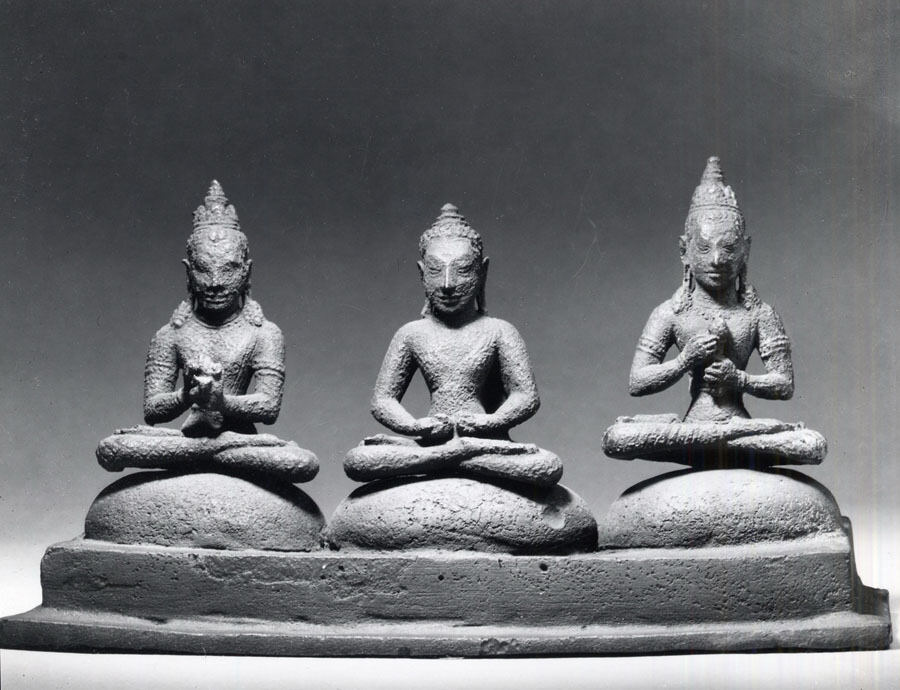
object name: figure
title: Buddhist Trinity on Cushions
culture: indonesian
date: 701-800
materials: bronze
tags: buddhism